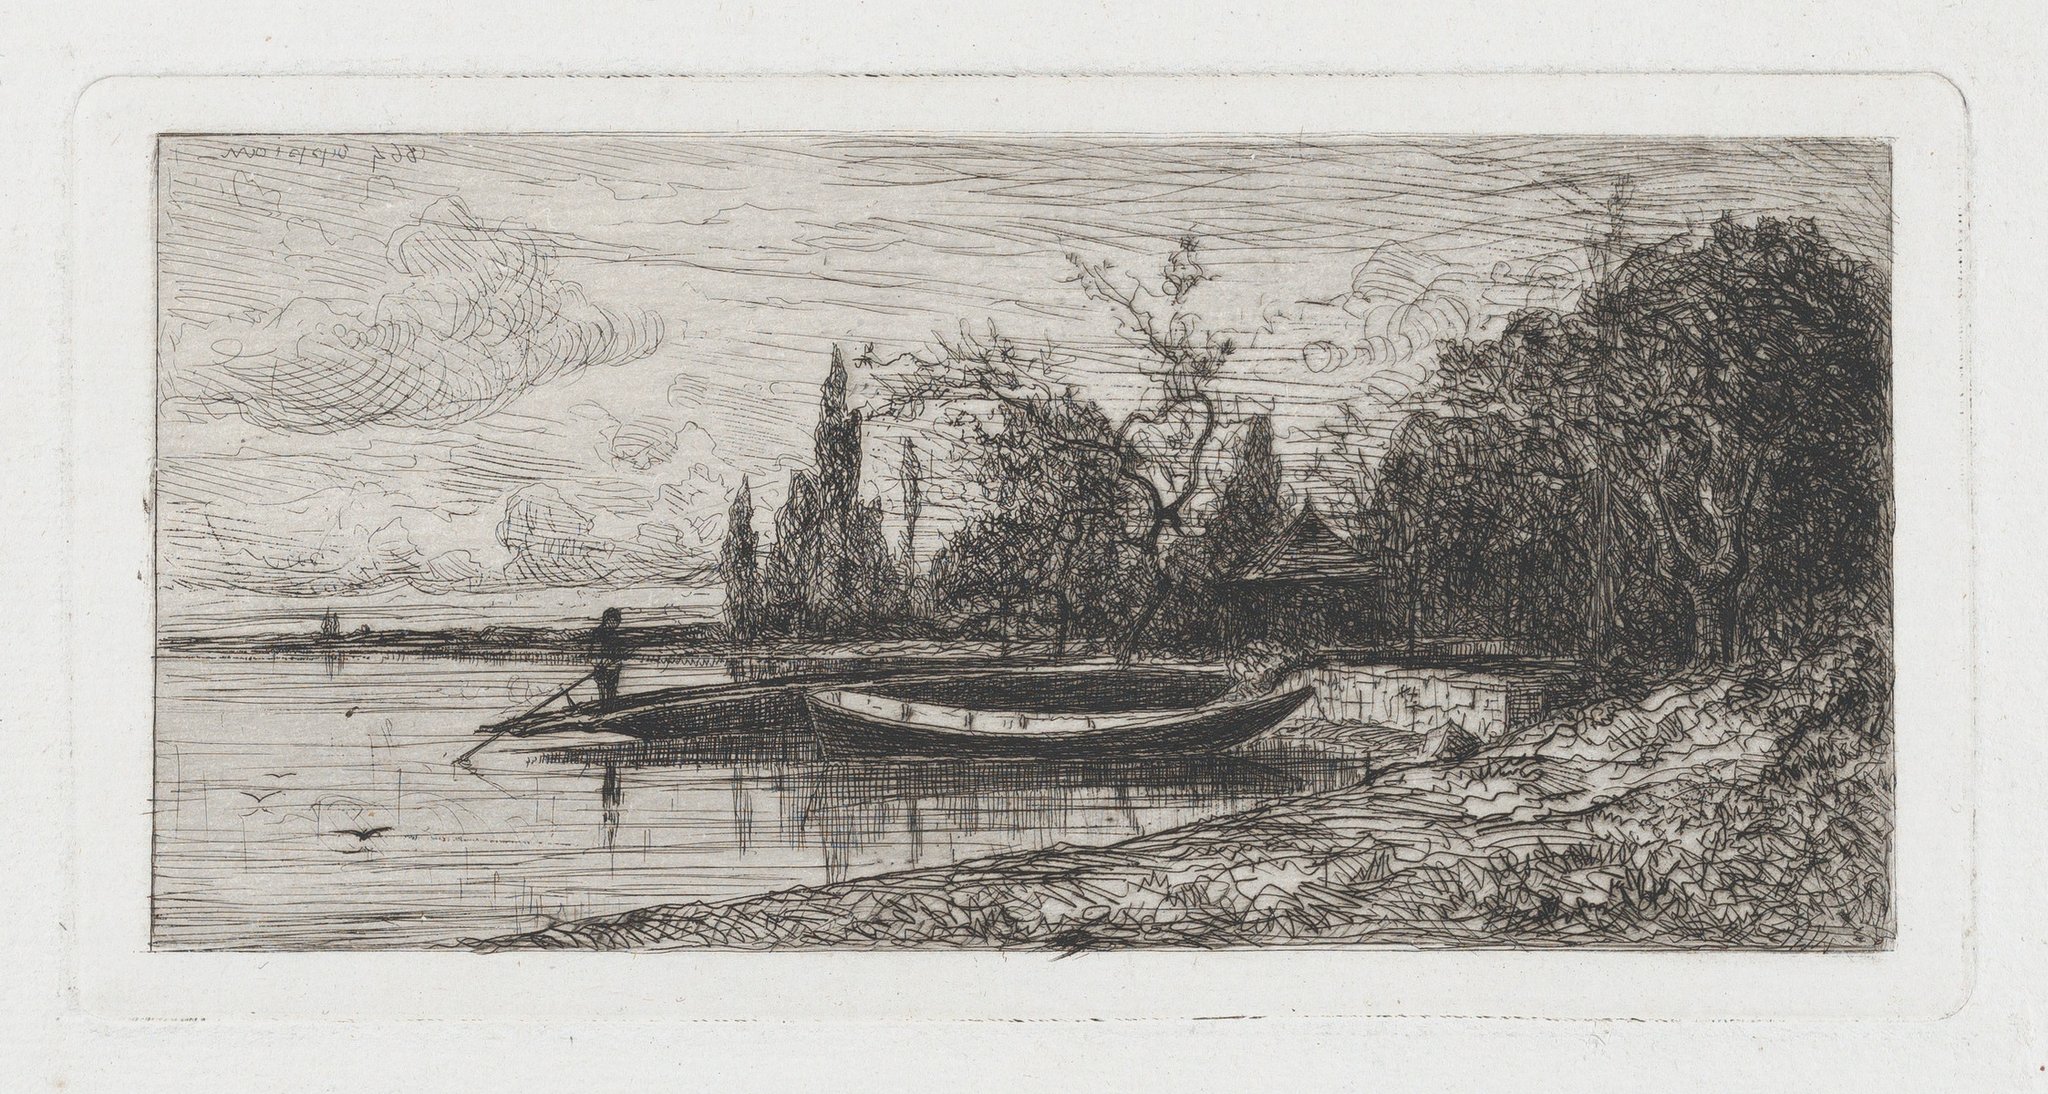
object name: print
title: Near the Rix (Ain)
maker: adolphe appian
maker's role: artist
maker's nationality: french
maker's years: 1818-1898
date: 1864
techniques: etching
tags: landscapes,boats